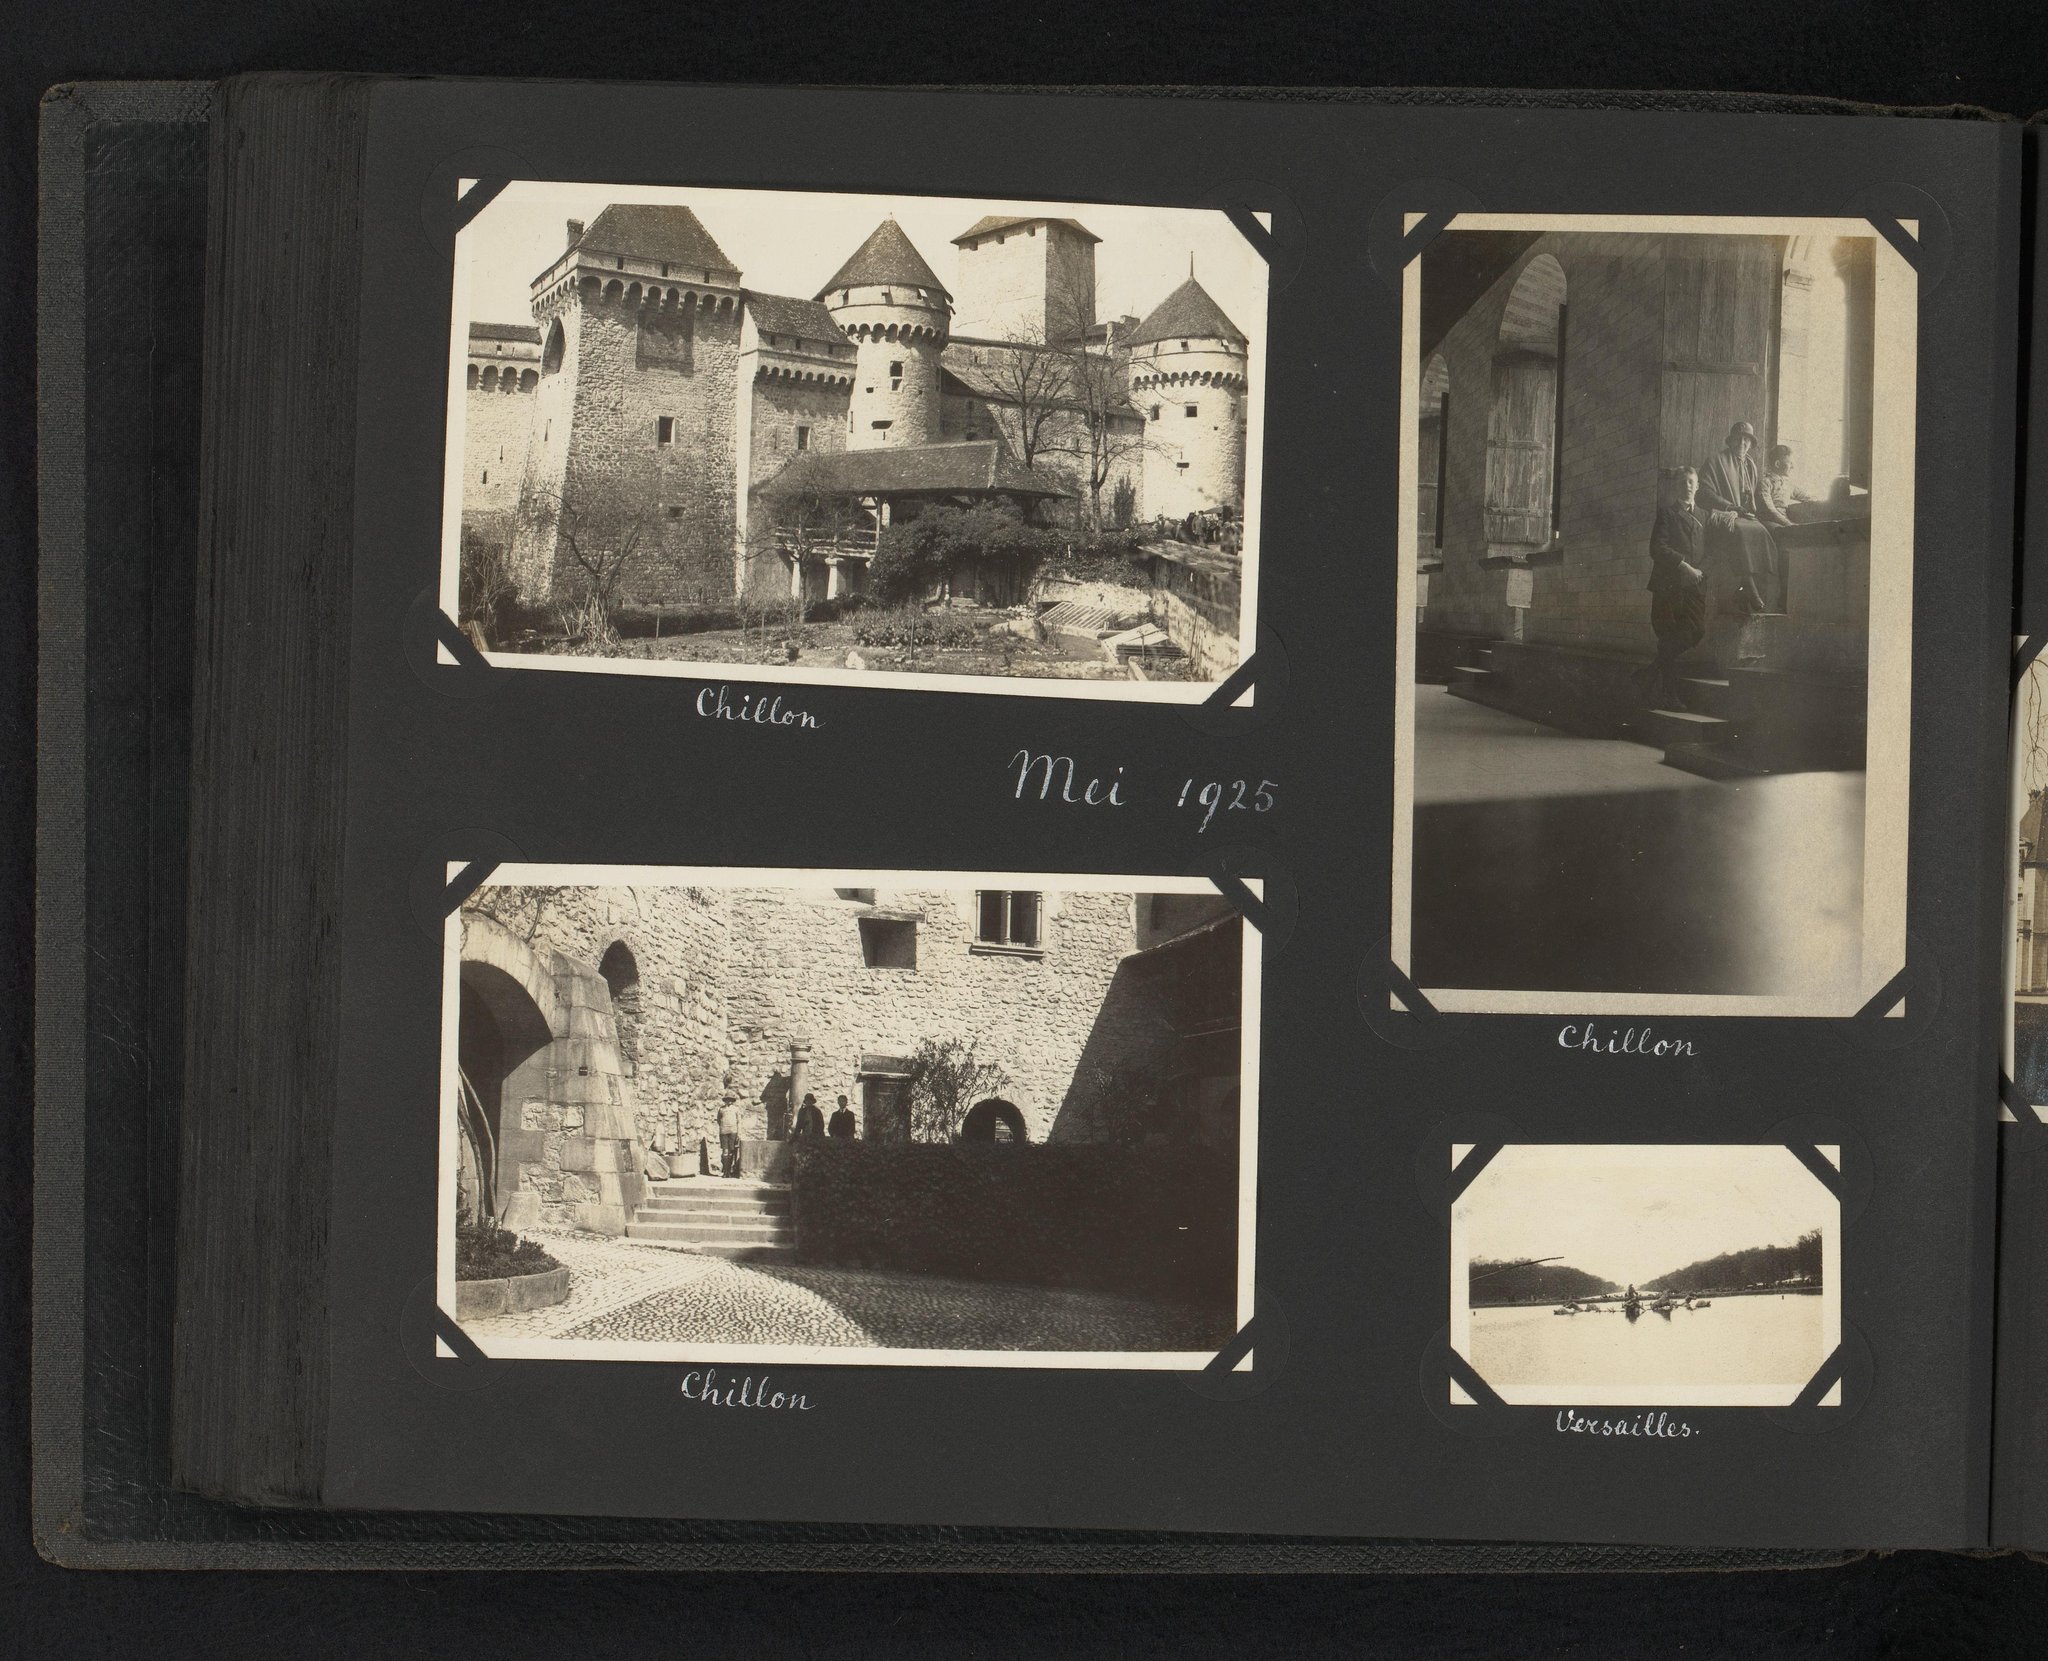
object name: album leaf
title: Mei 1925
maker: hendrik herman van den berg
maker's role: amateurfotograaf, jurist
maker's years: 1875-1944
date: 1905-1925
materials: paper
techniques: gelatin silver print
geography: europe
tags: the hague, caroline louise van den berg-van den berg, carel frederik van den berg (cay), amsterdam, frank willem van den berg (1912-1998), the family travelling, on holiday, castle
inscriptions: inscription: ‘Chillon’, inscription: ‘Chillon’, inscription: ‘Chillon’, inscription: ‘Versailles’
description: Deze foto's maken deel uit van een album.